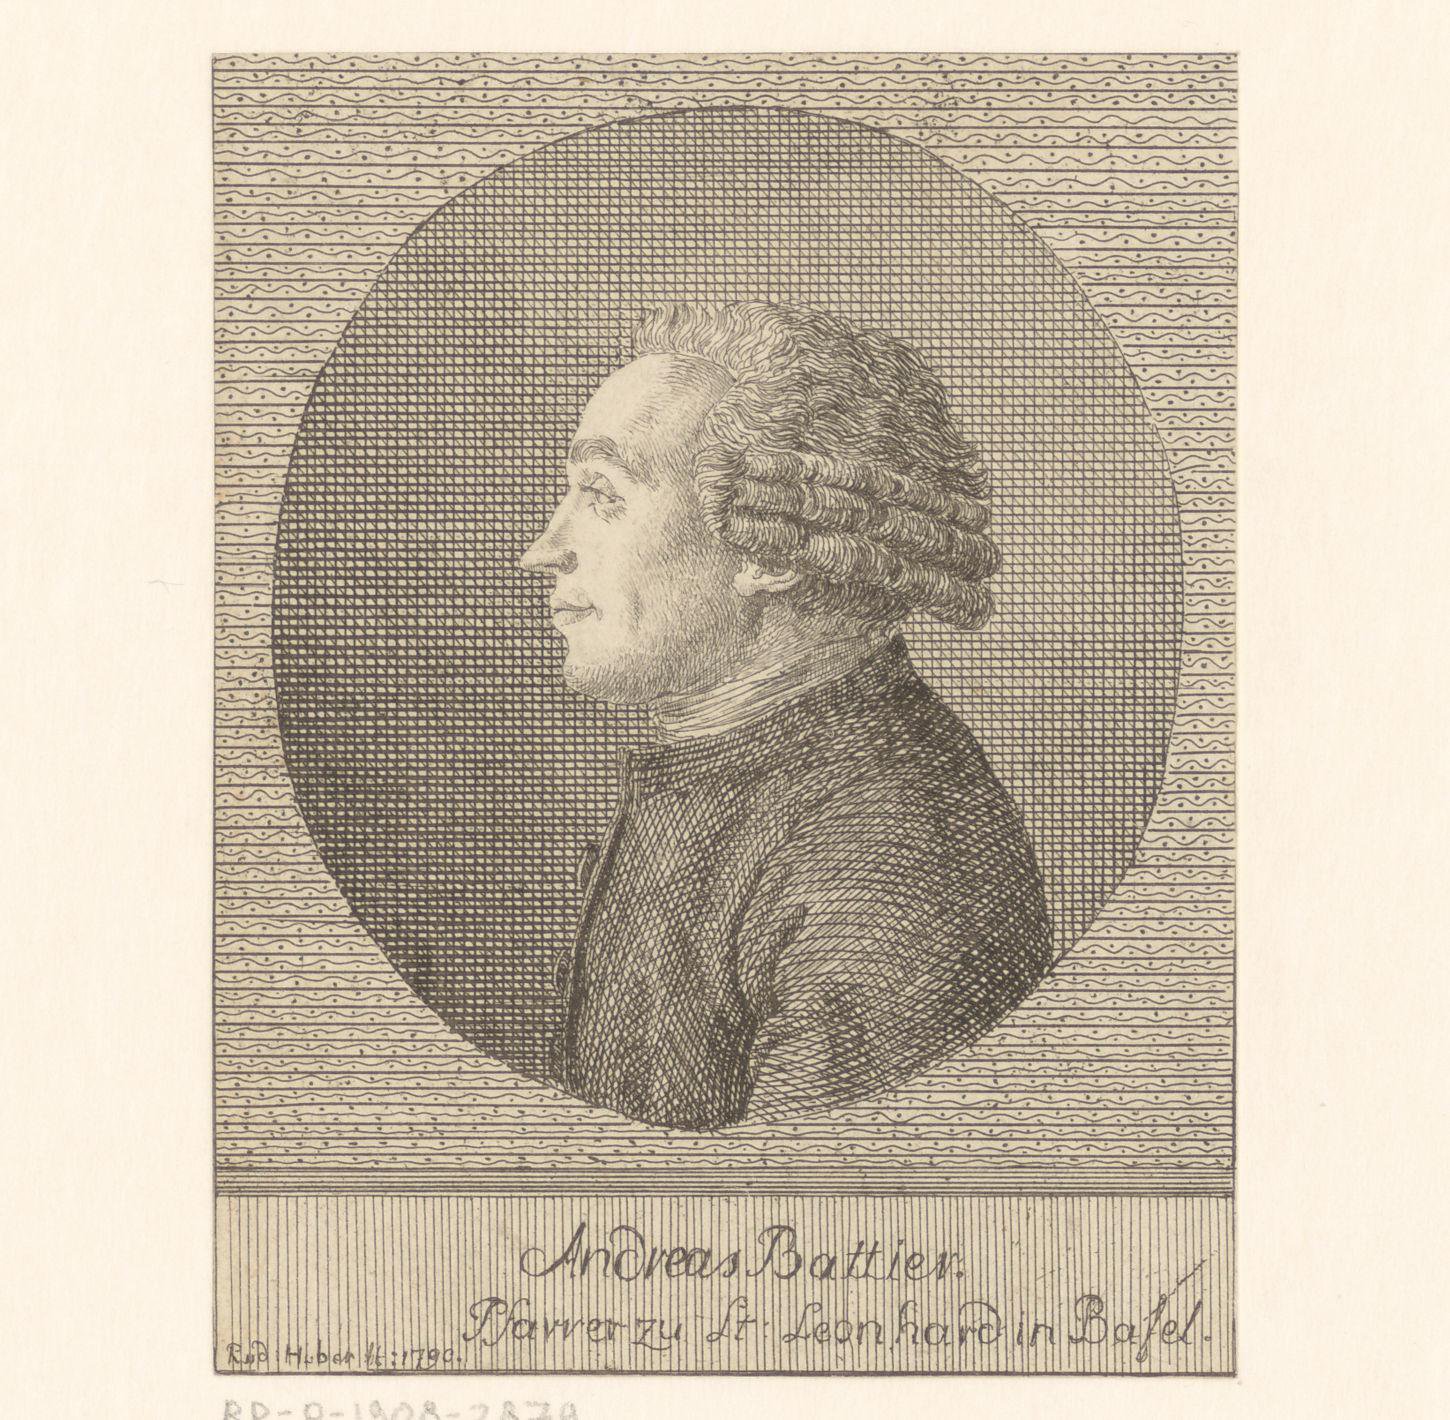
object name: print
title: Portret van Andreas Battier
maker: rudolf huber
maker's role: print maker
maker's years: 1770-1844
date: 1790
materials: paper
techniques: etching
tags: historical persons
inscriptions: collector's mark: Lugt 2228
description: Portret van Andreas Battier en profil naar links. Tekst in Latijn in de marge.